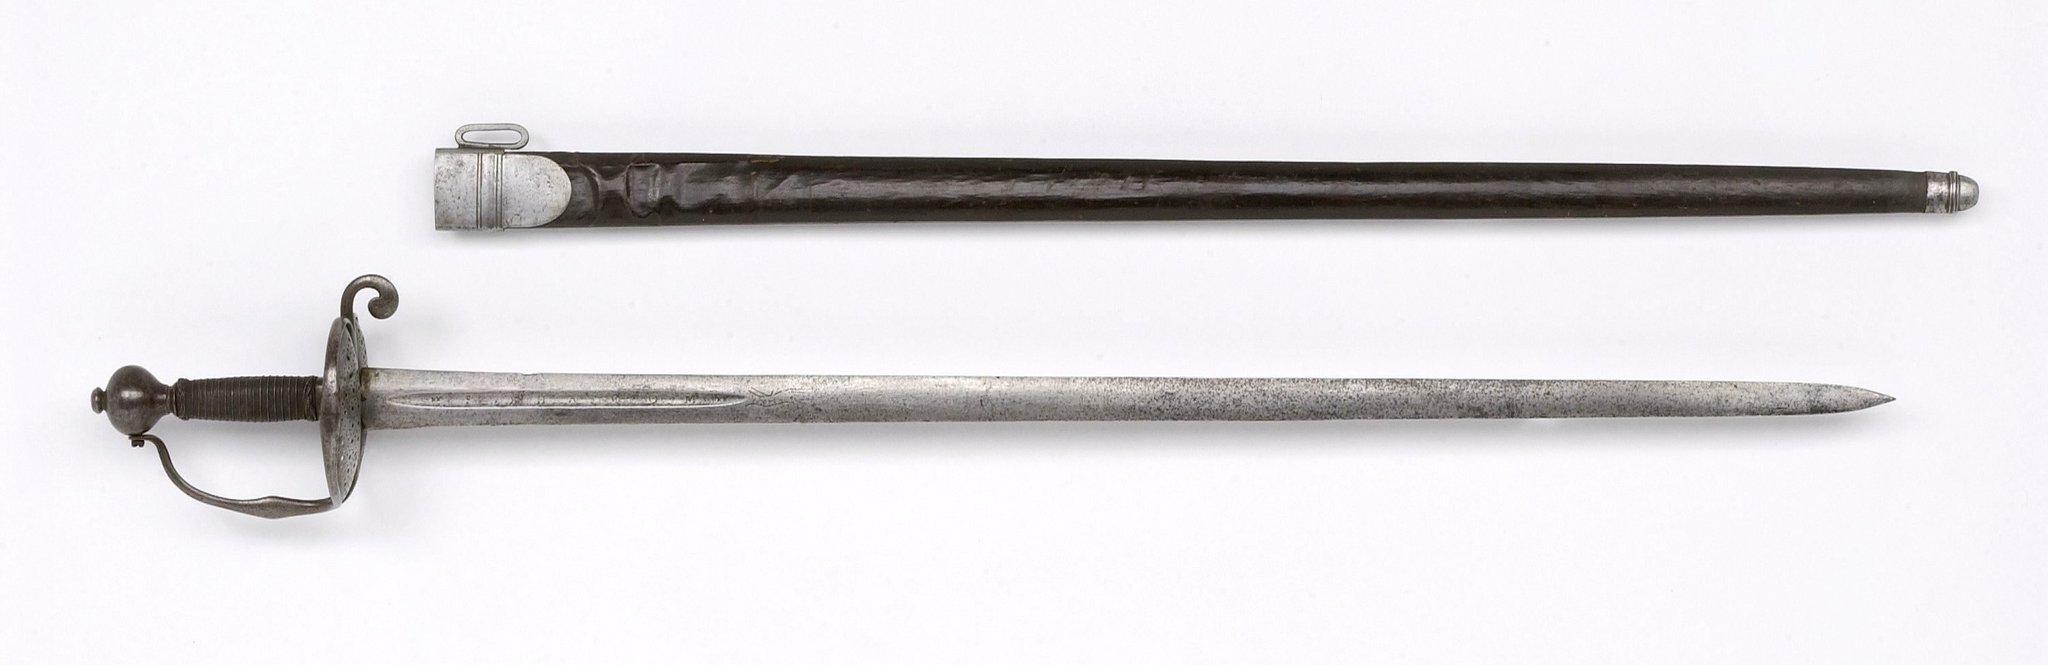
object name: sword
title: Zwaard met schede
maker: Anonymous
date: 1650-1660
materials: iron, oilcloth, wood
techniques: printing, embroidery, upholstery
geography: wallonia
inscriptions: mark: ‘SAHAGOM’, mark: ‘BC’